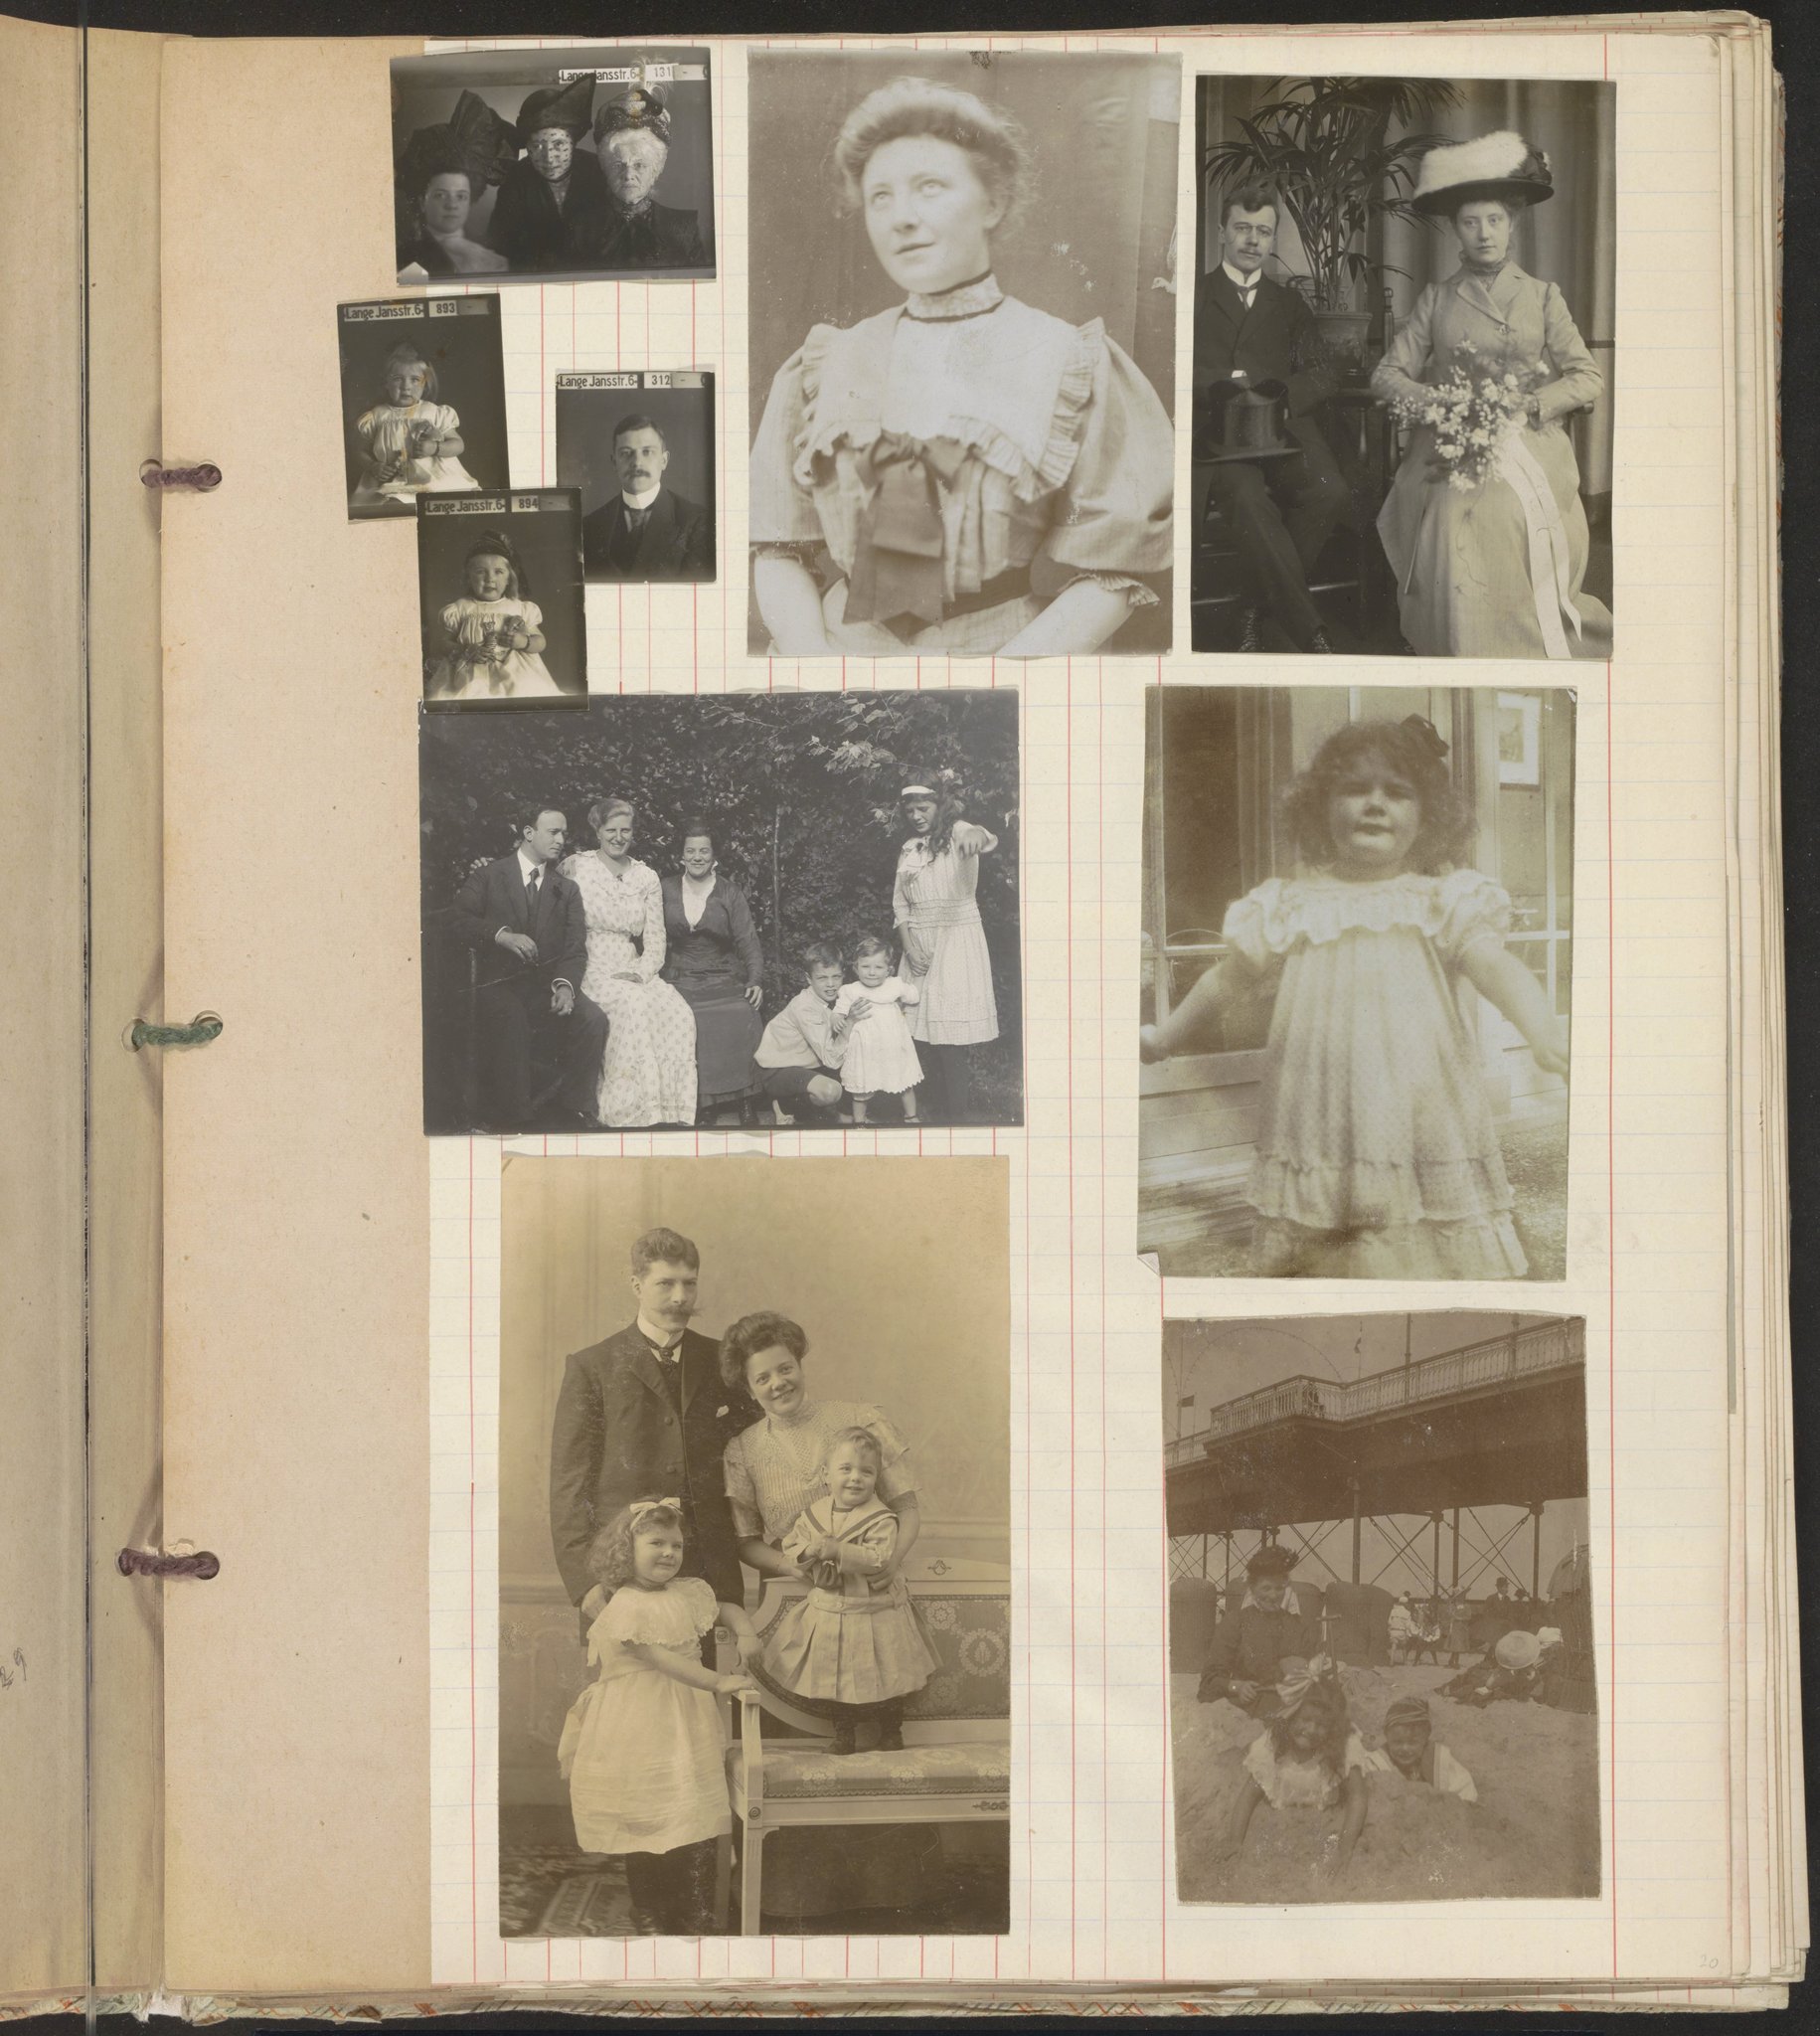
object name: photograph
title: Portretten van onbekende personen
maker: Anonymous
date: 1900-1920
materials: paper, photographic support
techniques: gelatin silver print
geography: netherlands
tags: adult woman, parents with their children, adult man, child, marriage, married couple, 'matrimonium', pier, quay, wharf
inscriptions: number: ‘131, 312, 894, 893’, address: ‘Lange Jansstr. 6’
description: Albumblad met portretten van volwassenen en kinderen, waaronder een huwelijksportret. Ook een foto van kinderen spelend aan het strand bij een pier. Onderdeel van Fotoalbum van de familie Petri.